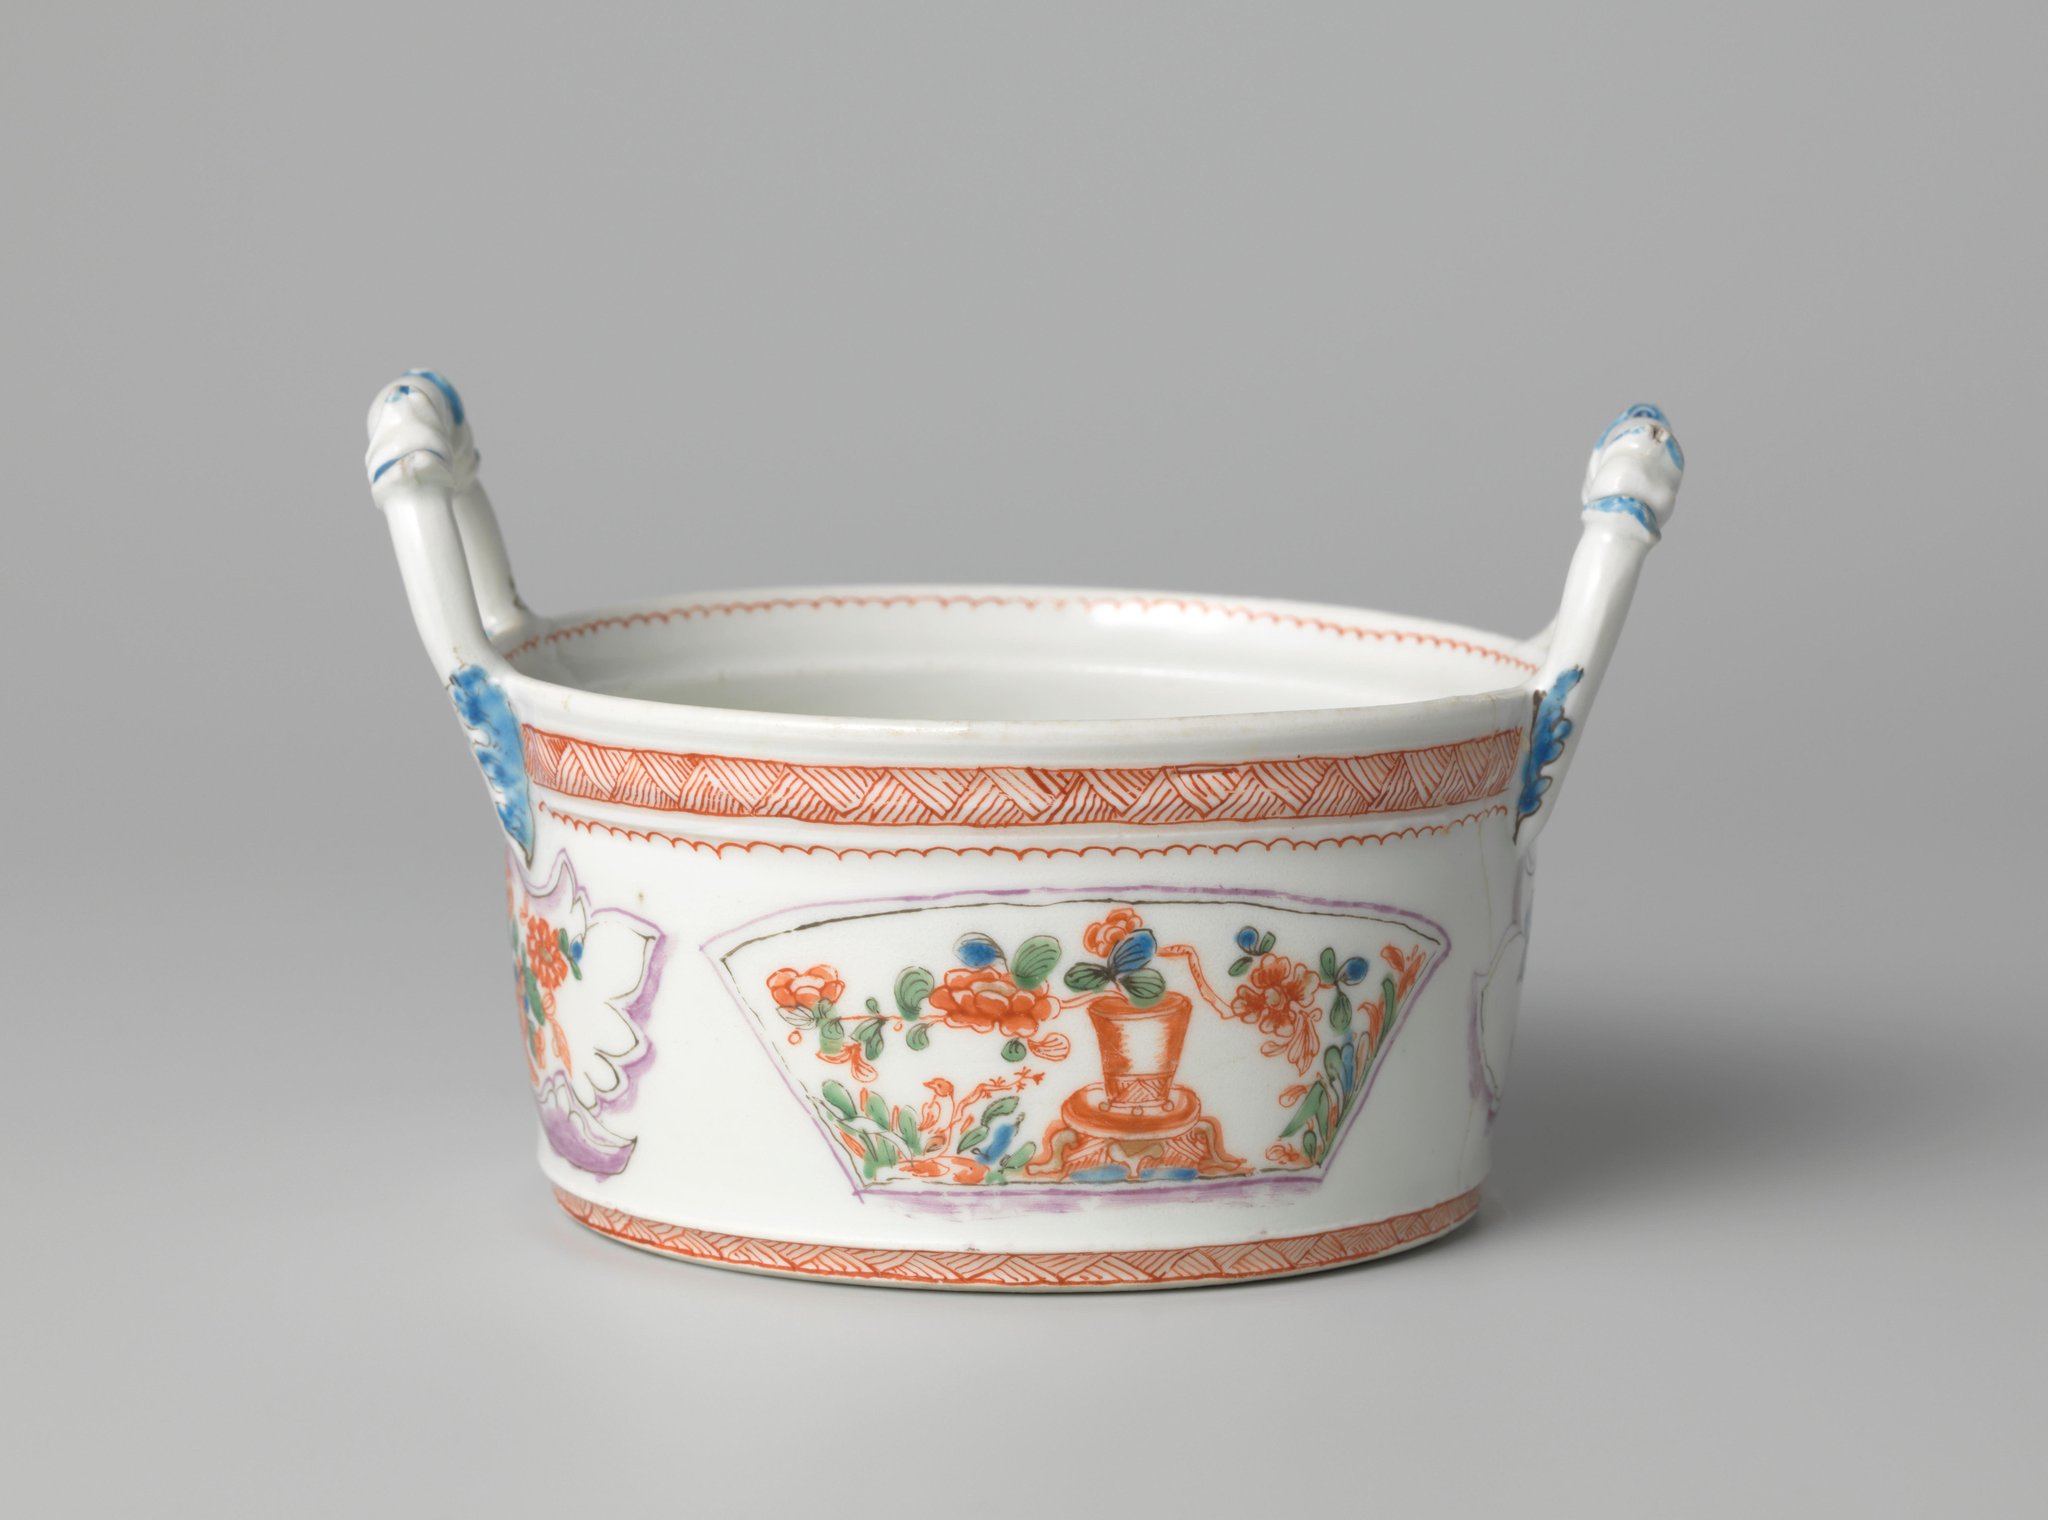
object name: butter dish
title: Butter tub with flower vases in panels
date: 1719-1744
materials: glaze, gold, paint, porcelain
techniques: firing, forming, gilding, turning, vitrification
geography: vienna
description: Rond bakje met geprofileerde mond- en voetrand en twee opstaande oren. Mond- en voetrand zijn versierd met een strook, bestaande uit een gearceerd zig-zag-motief in rood. Op het lichaam afwisselend in een violet gerande bladcartouche en dito trapeziumvormige reserve bloemen in een vaas, welke soms op een driepotig tafeltje staat. Beschildering in blauw, lichtrood, groen, zwart, goud en violet. Op de oren blauwe blaadjes. Weens porselein,Du Paquier. Het bakje was in twee stukken gebroken en is daarna hersteld.